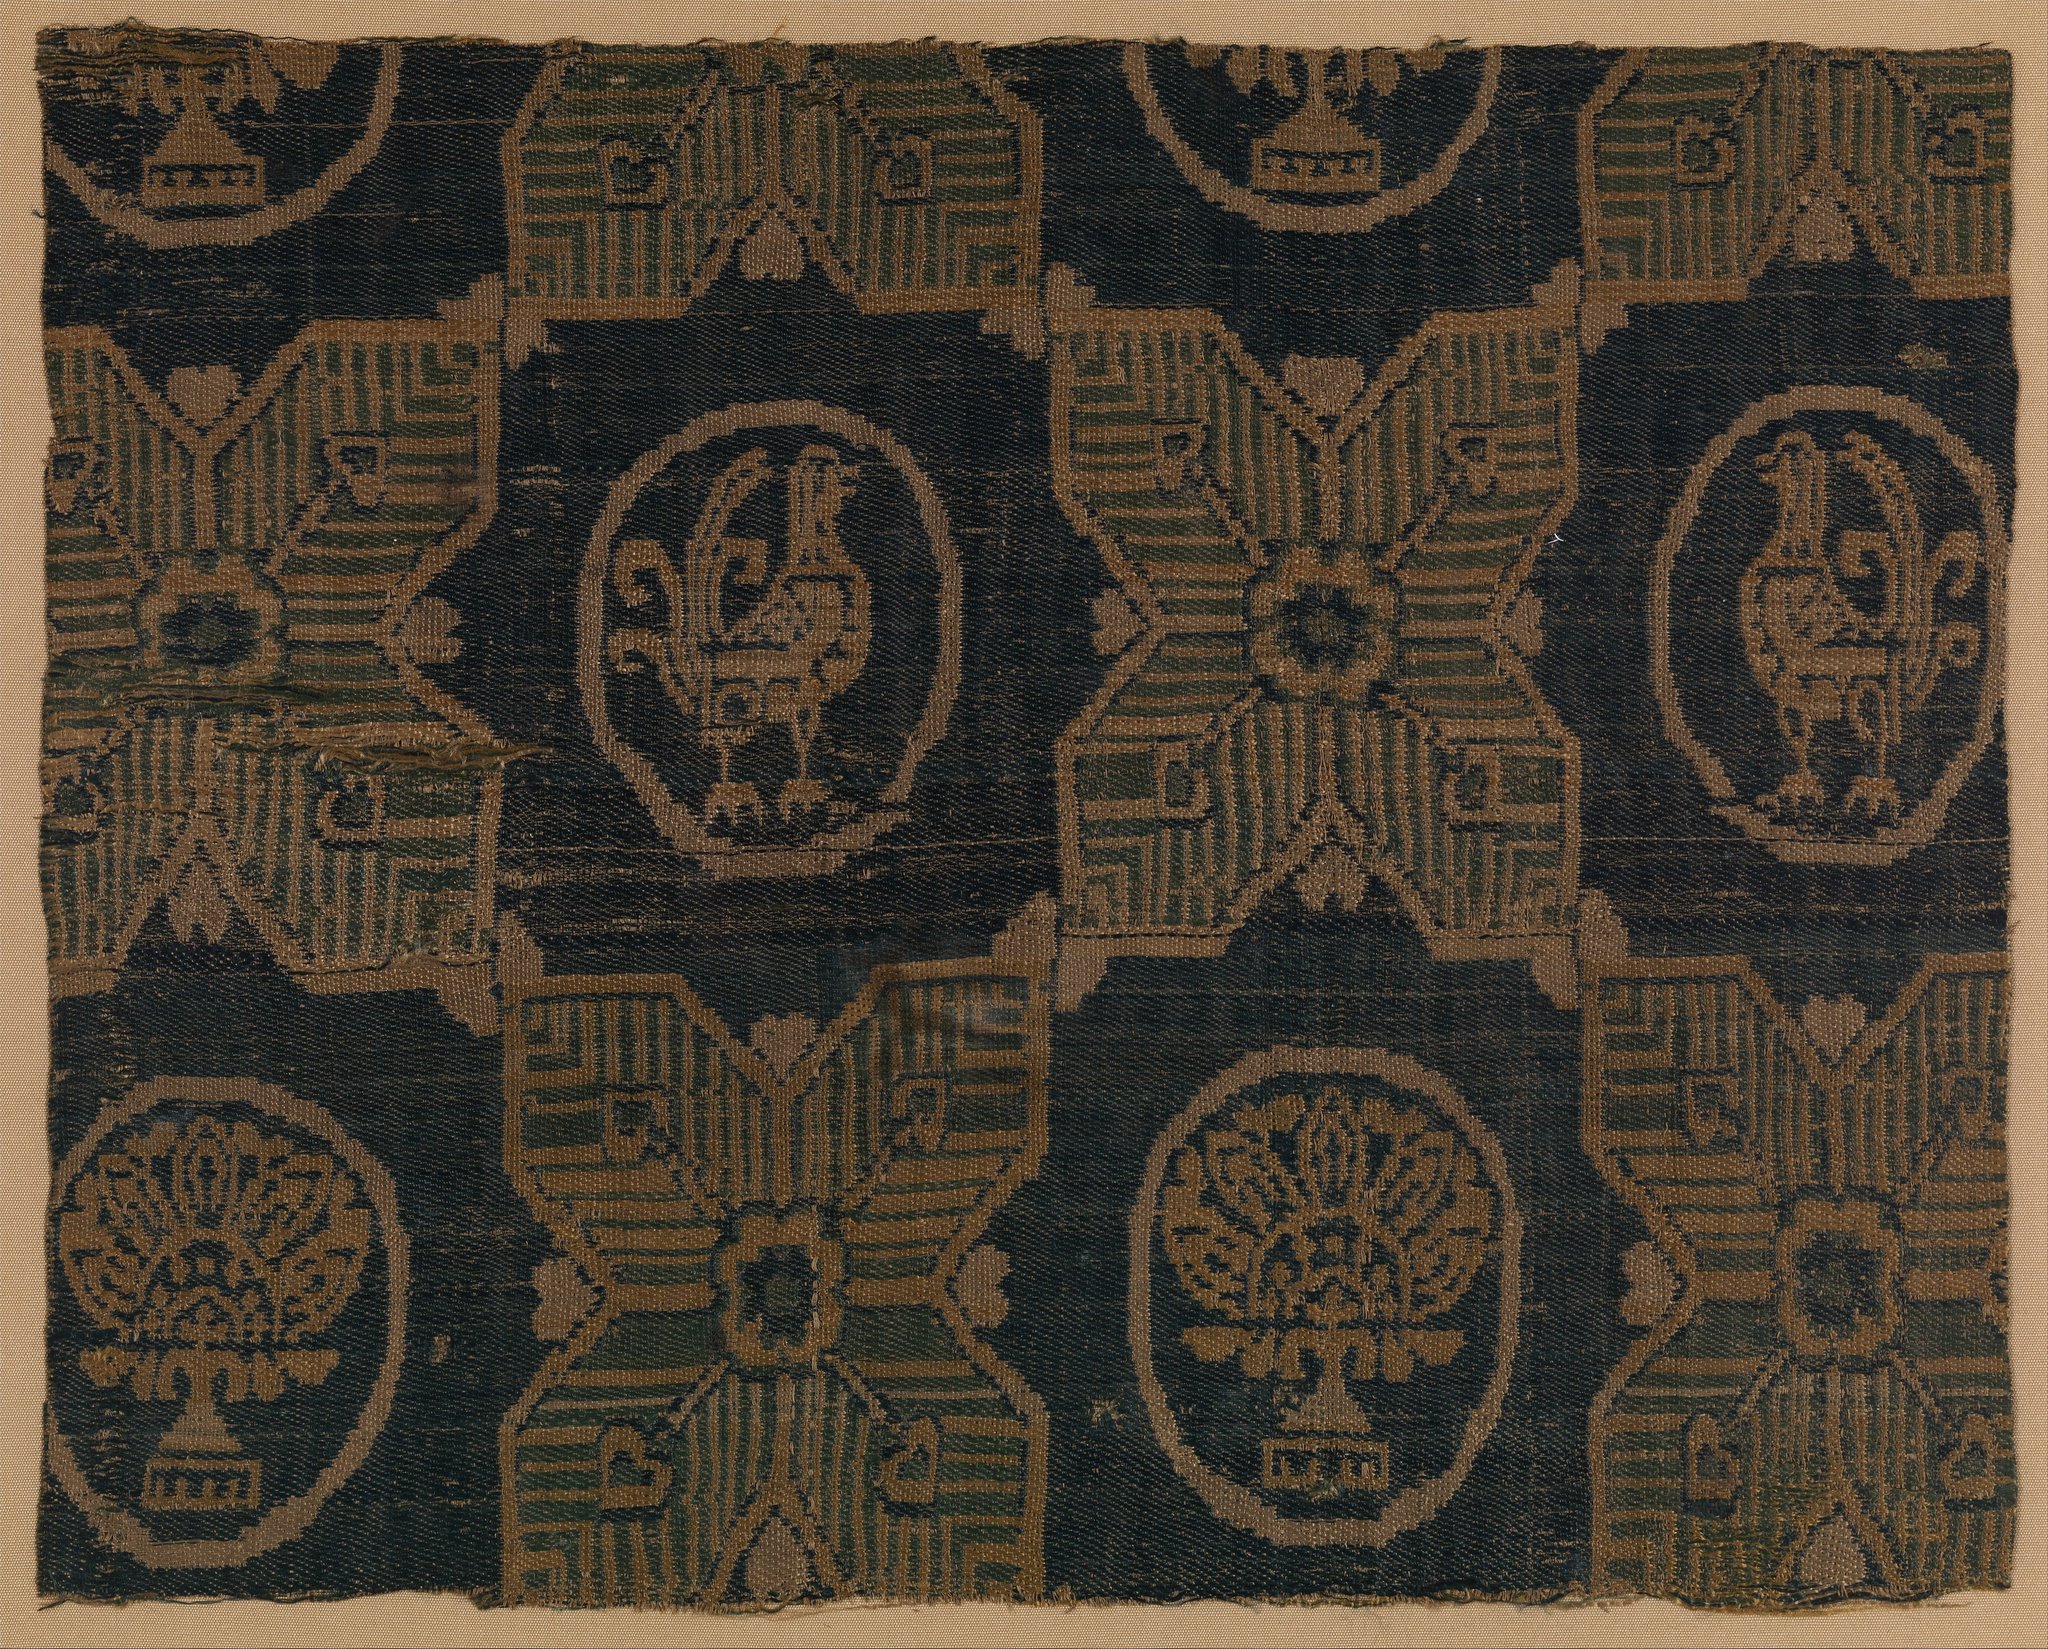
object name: textile fragment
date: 701-900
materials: silk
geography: iran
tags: birds